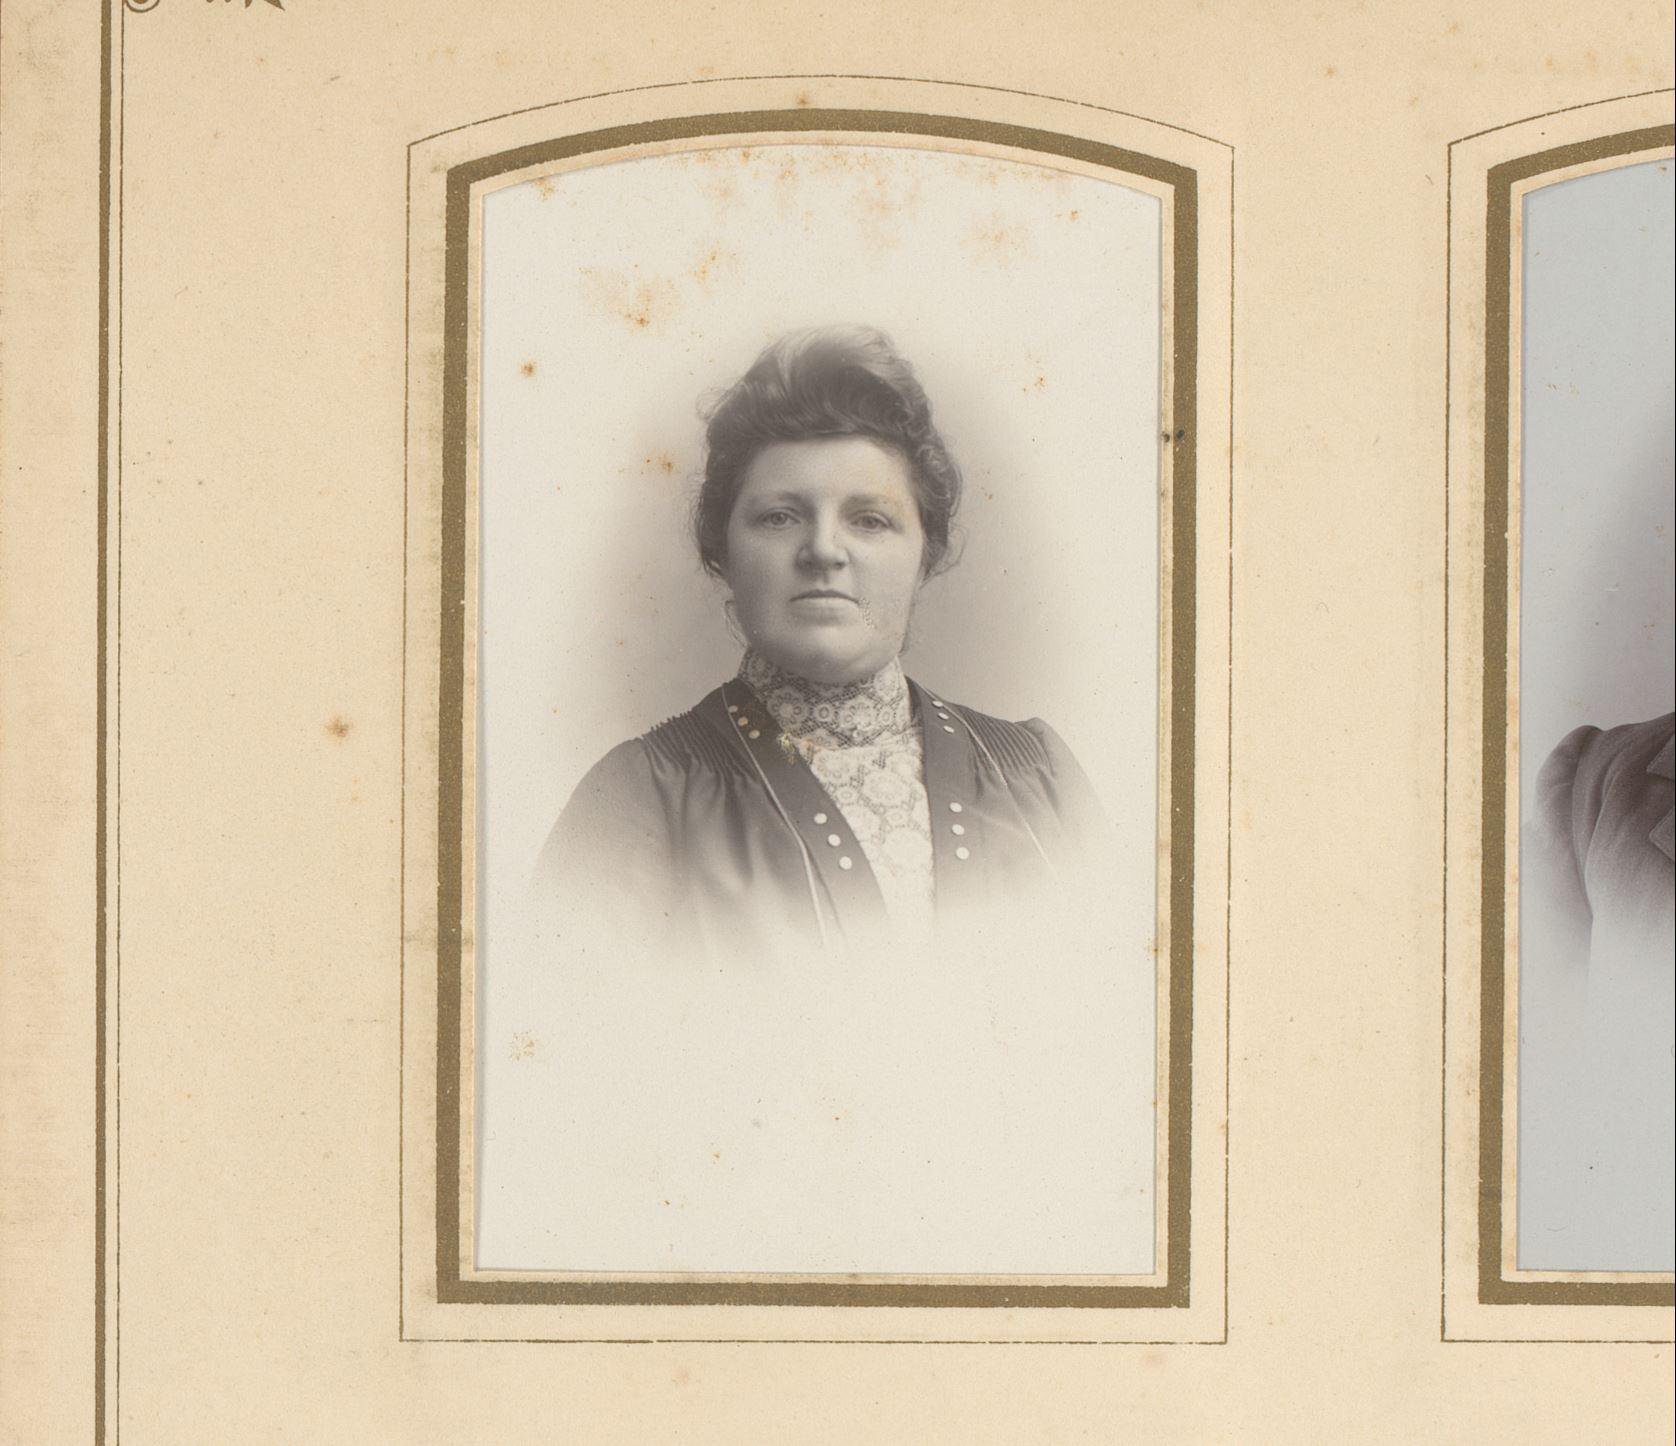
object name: carte de visite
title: Portret van een vrouw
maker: reinier uges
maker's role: fotograaf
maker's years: 1871-1945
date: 1894-1898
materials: cardboard, photographic support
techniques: collodion silver print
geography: groningen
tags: historical persons - bb - woman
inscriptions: inscription: ‘Atelier Uges/ GRONINGEN/ OOSERSTRAAT 36a’